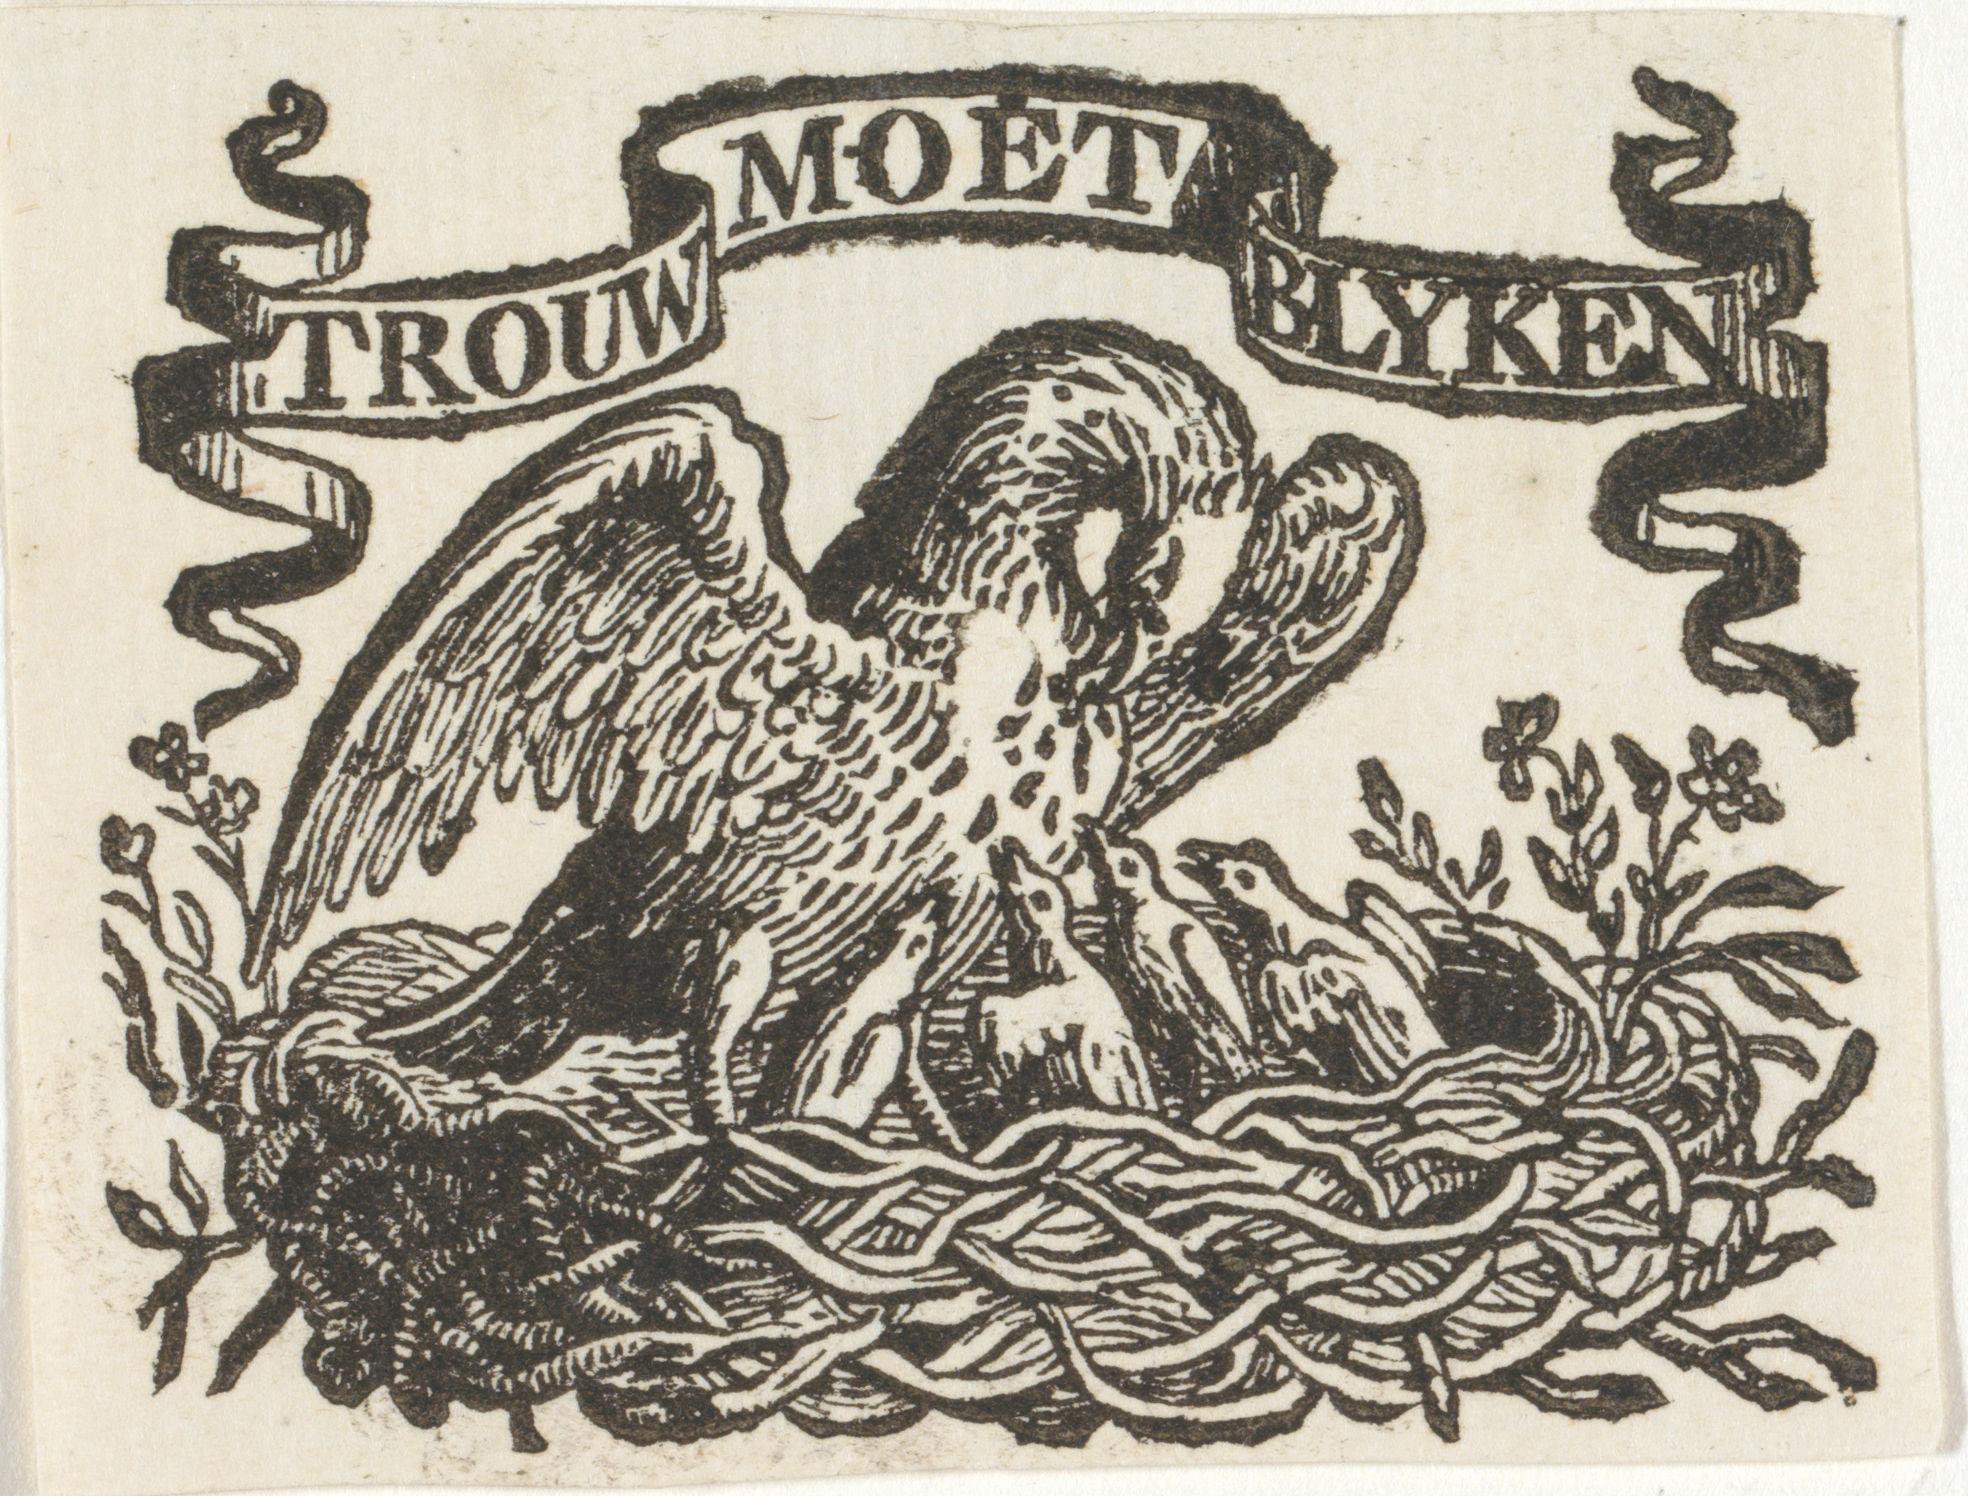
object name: print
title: Vignet van de rederijkerskamer 'Trouw moet blyken' te Haarlem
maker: cornelis van noorde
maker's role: draughtsman, print maker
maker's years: 1731-1795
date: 1741-1795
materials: paper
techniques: woodcut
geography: haarlem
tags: chamber of rhetoric (dutch: 'rederijkerskamer'), vignette, water-birds: pelican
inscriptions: collector's mark: Lugt 2228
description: Een pelikaan met vier jongen in haar nest.